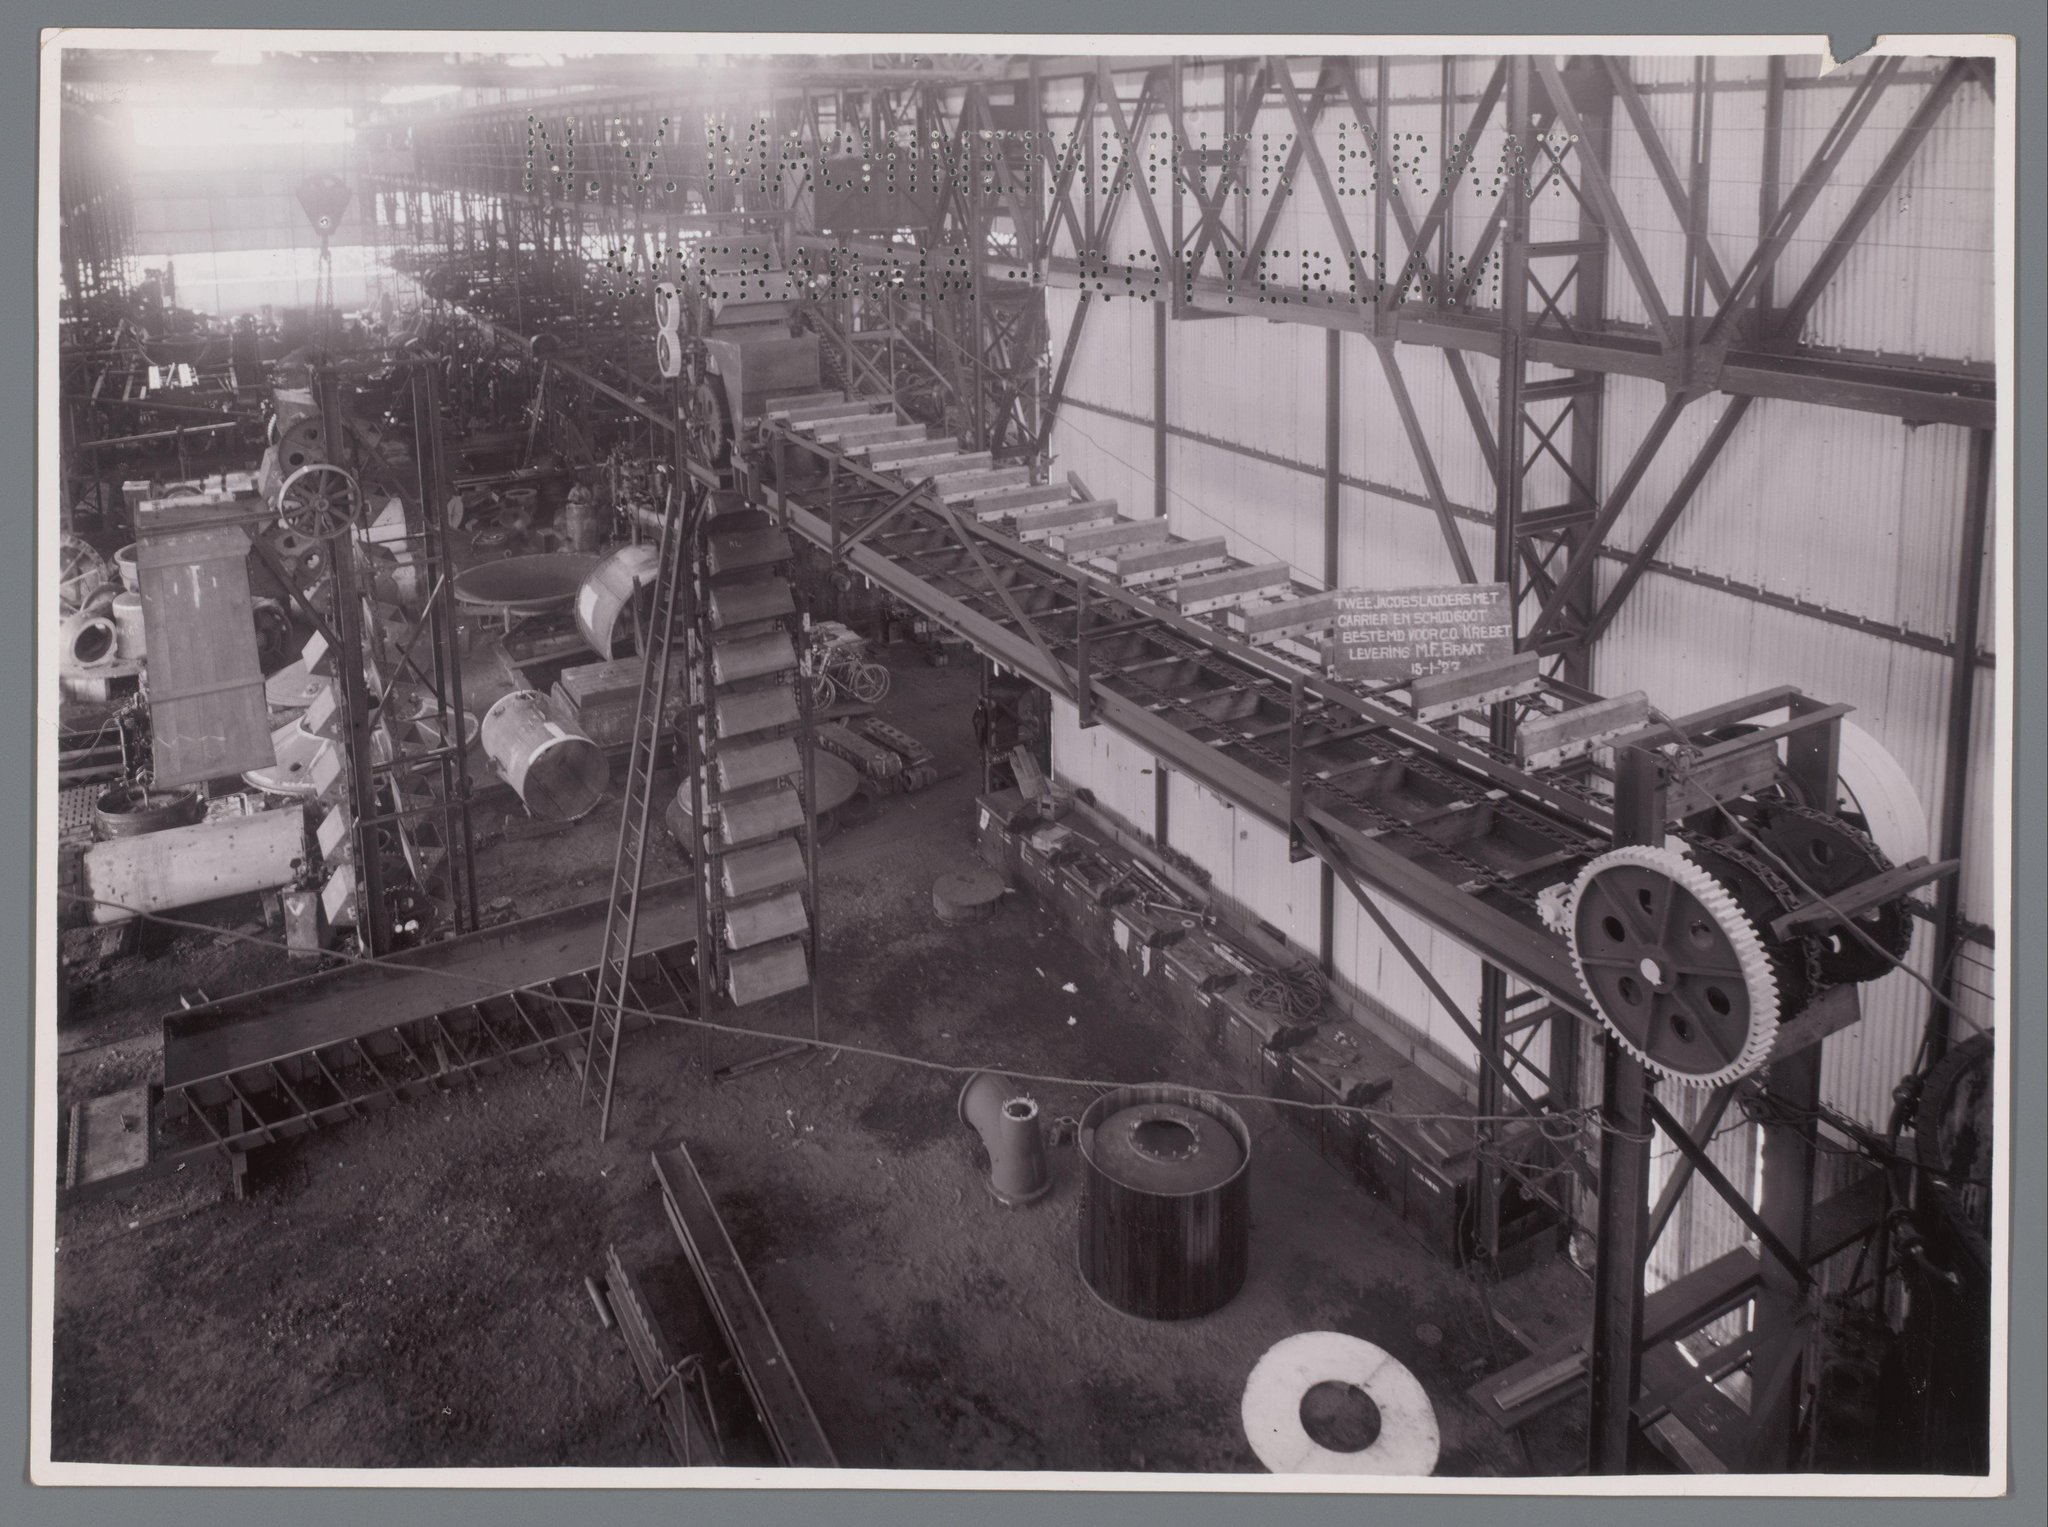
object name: photograph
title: Transportbanden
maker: Anonymous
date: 1927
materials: photographic support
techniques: gelatin silver print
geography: surabaya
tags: colonial system, factory-interior, machine shop, machines; parts of machines; tools and appliances, java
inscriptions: company name: ‘N.V. Machinefabriek Braat / Soerabaia – Rotterdam’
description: Twee transportbanden, jacobsladders, vervaardigd in 1927 en bestemd voor de cultuuronderneming Krebet te Malang. Onderdeel van de multomap met foto's van machines van de N.V. Machinefabriek Braat te Soerabaja, Soekaboemi en Jogyakarta, uit de periode 1908-1942.